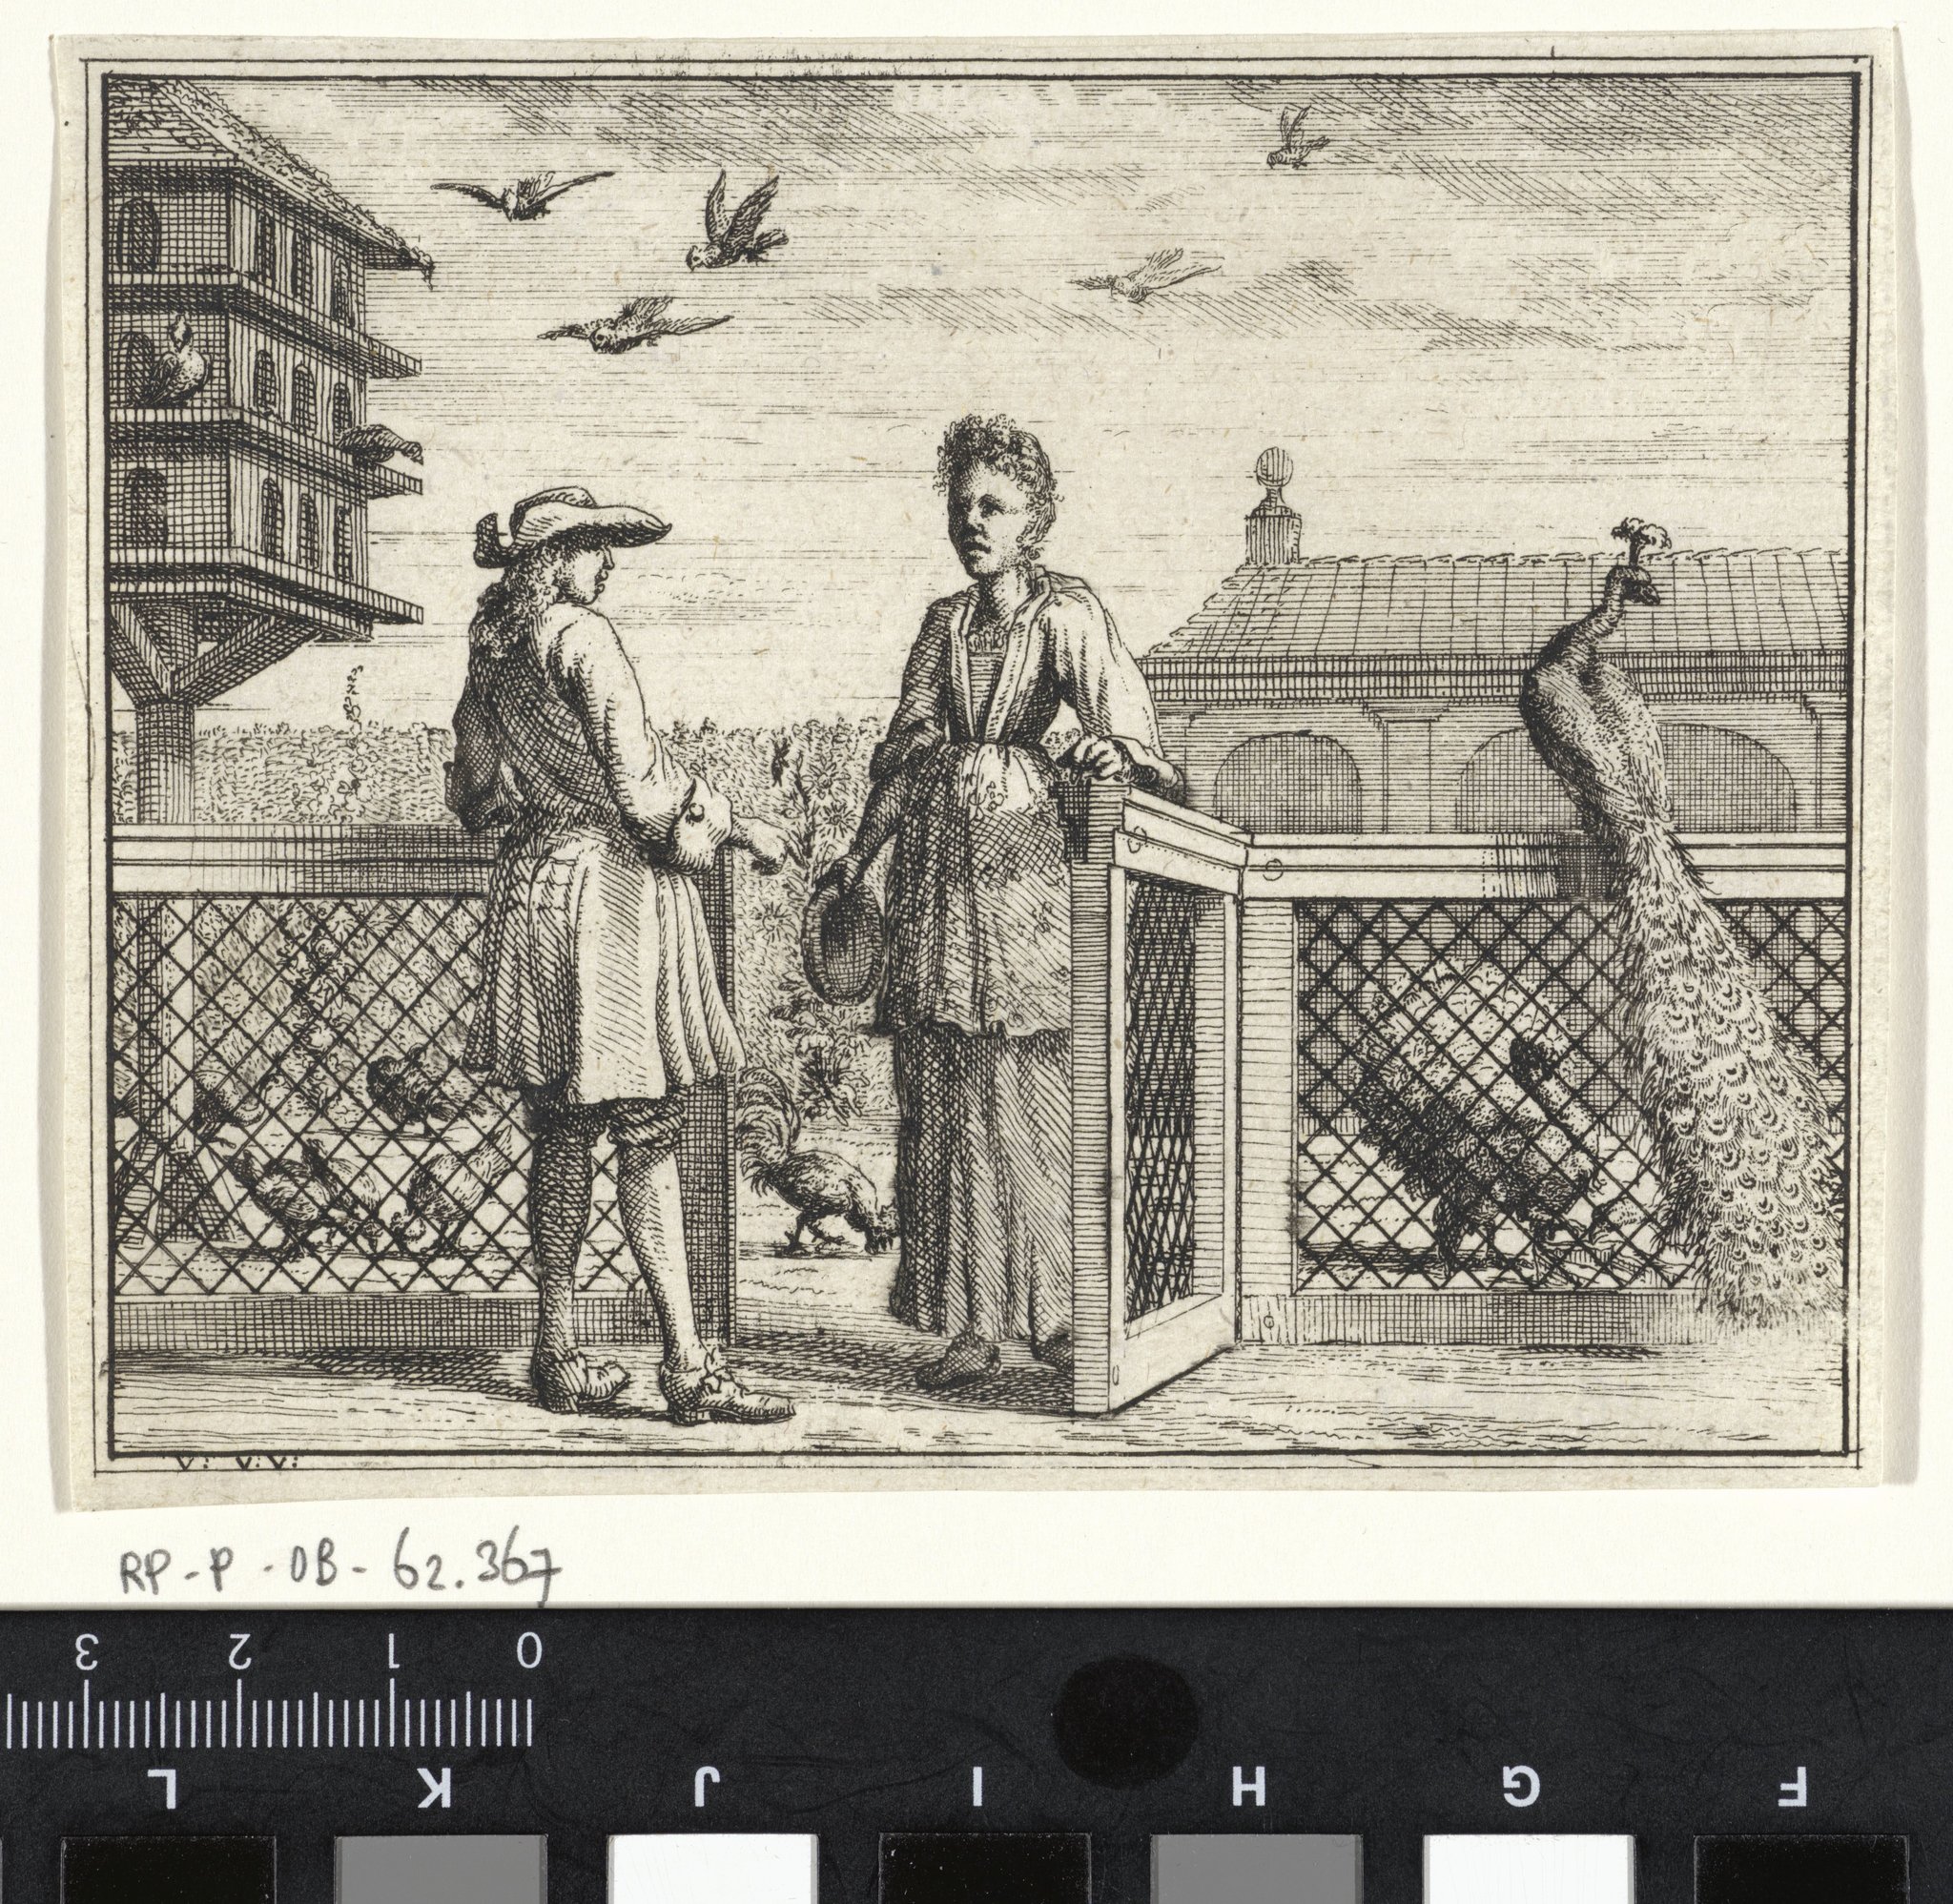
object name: print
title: Man in gesprek met een vrouw bij een volière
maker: vincent laurensz. van der vinne (ii)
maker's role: draughtsman, print maker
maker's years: 1686-1742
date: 1714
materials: paper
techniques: engraving, etching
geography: haarlem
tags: nesting-box, caring for birds, birds (+ animals used symbolically), fence, wall, paling, dove-cote, ornamental birds: peacock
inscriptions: collector's mark: Lugt 2228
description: Een man is in gesprek met een vrouw, die met en lege mand bij het hek staat van een volière. Links op het hek een pauw. Zinnebeeld op het vertrouwen dat men stelt iets terug te ontvangen voor aardse daden, terwijl men alleen op God kan vertrouwen.